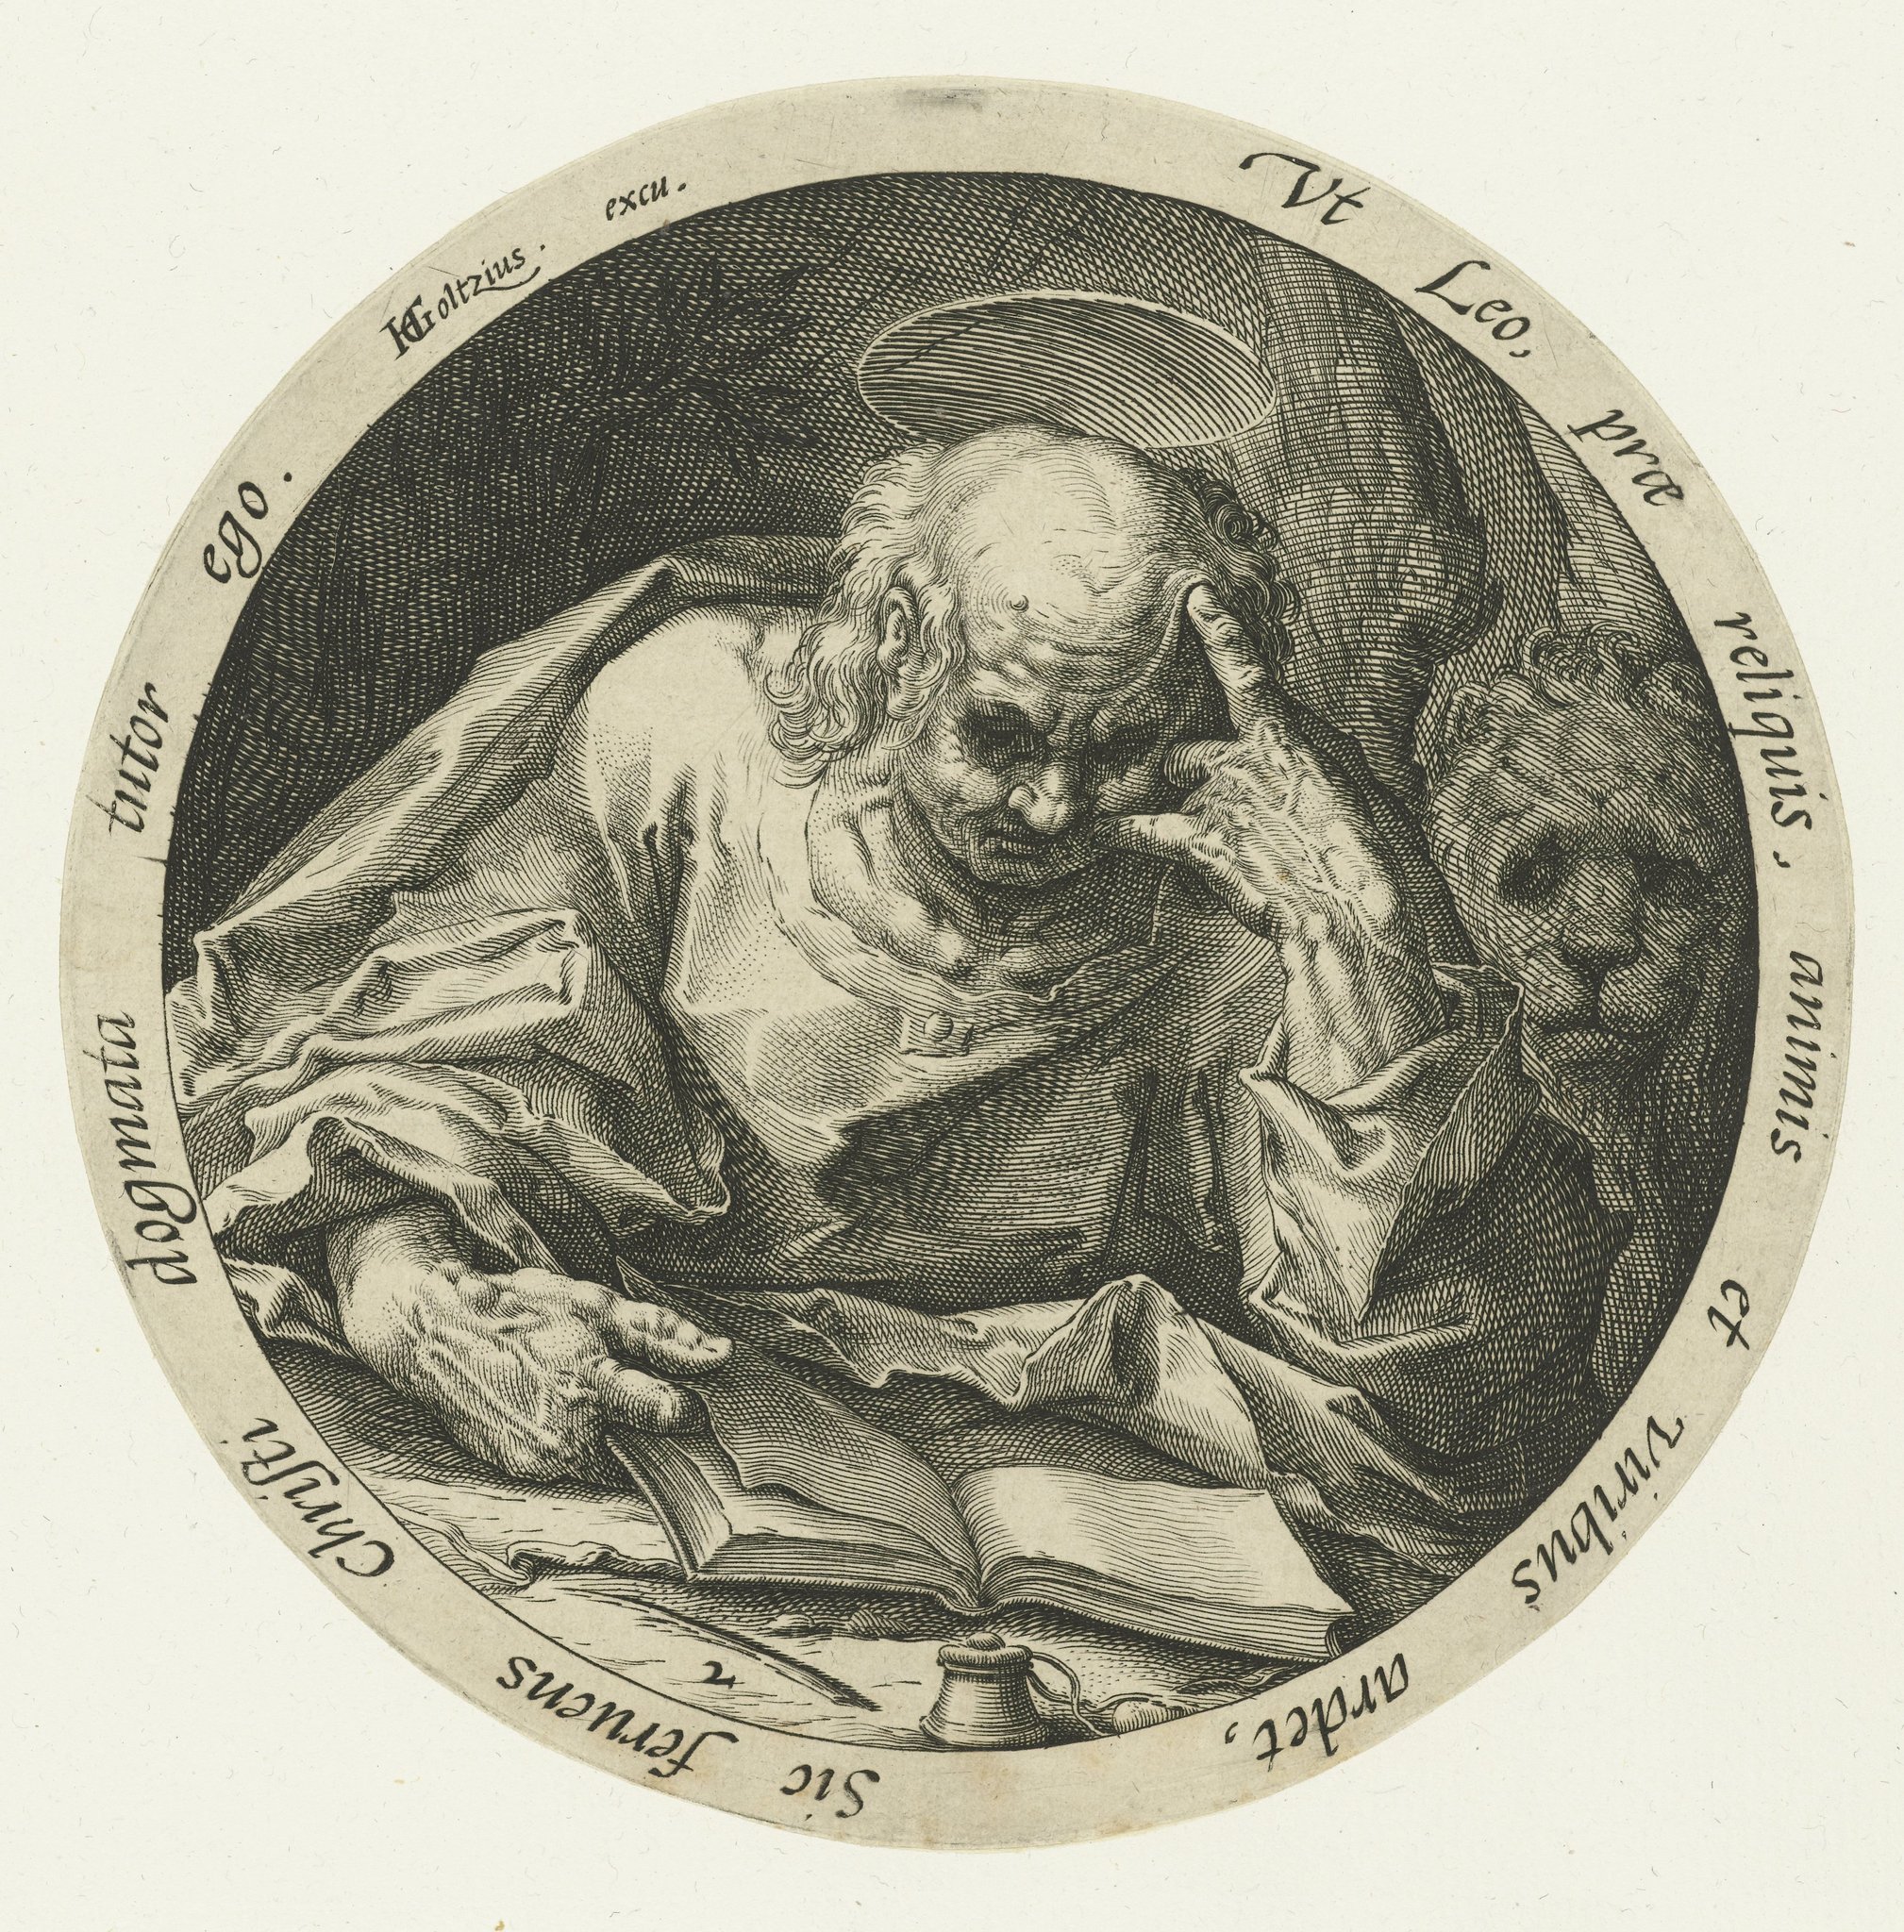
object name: print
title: Evangelist Marcus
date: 1588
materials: paper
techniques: engraving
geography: netherlands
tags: mark (marcus) the evangelist, and bishop of alexandria; possible attributes: book, (winged) lion, pen and inkhorn, scroll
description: Marcus de evangelist, ten halven lijve, lezend in een boek. Aan zijn linkerzijde staat een gevleugelde leeuw. Om de voorstelling een Latijnse tekst. Deze prent is onderdeel van een serie van vier ronde voorstellingen van de evangelisten, elk omgeven door een witte band waarin een regel Latijn.